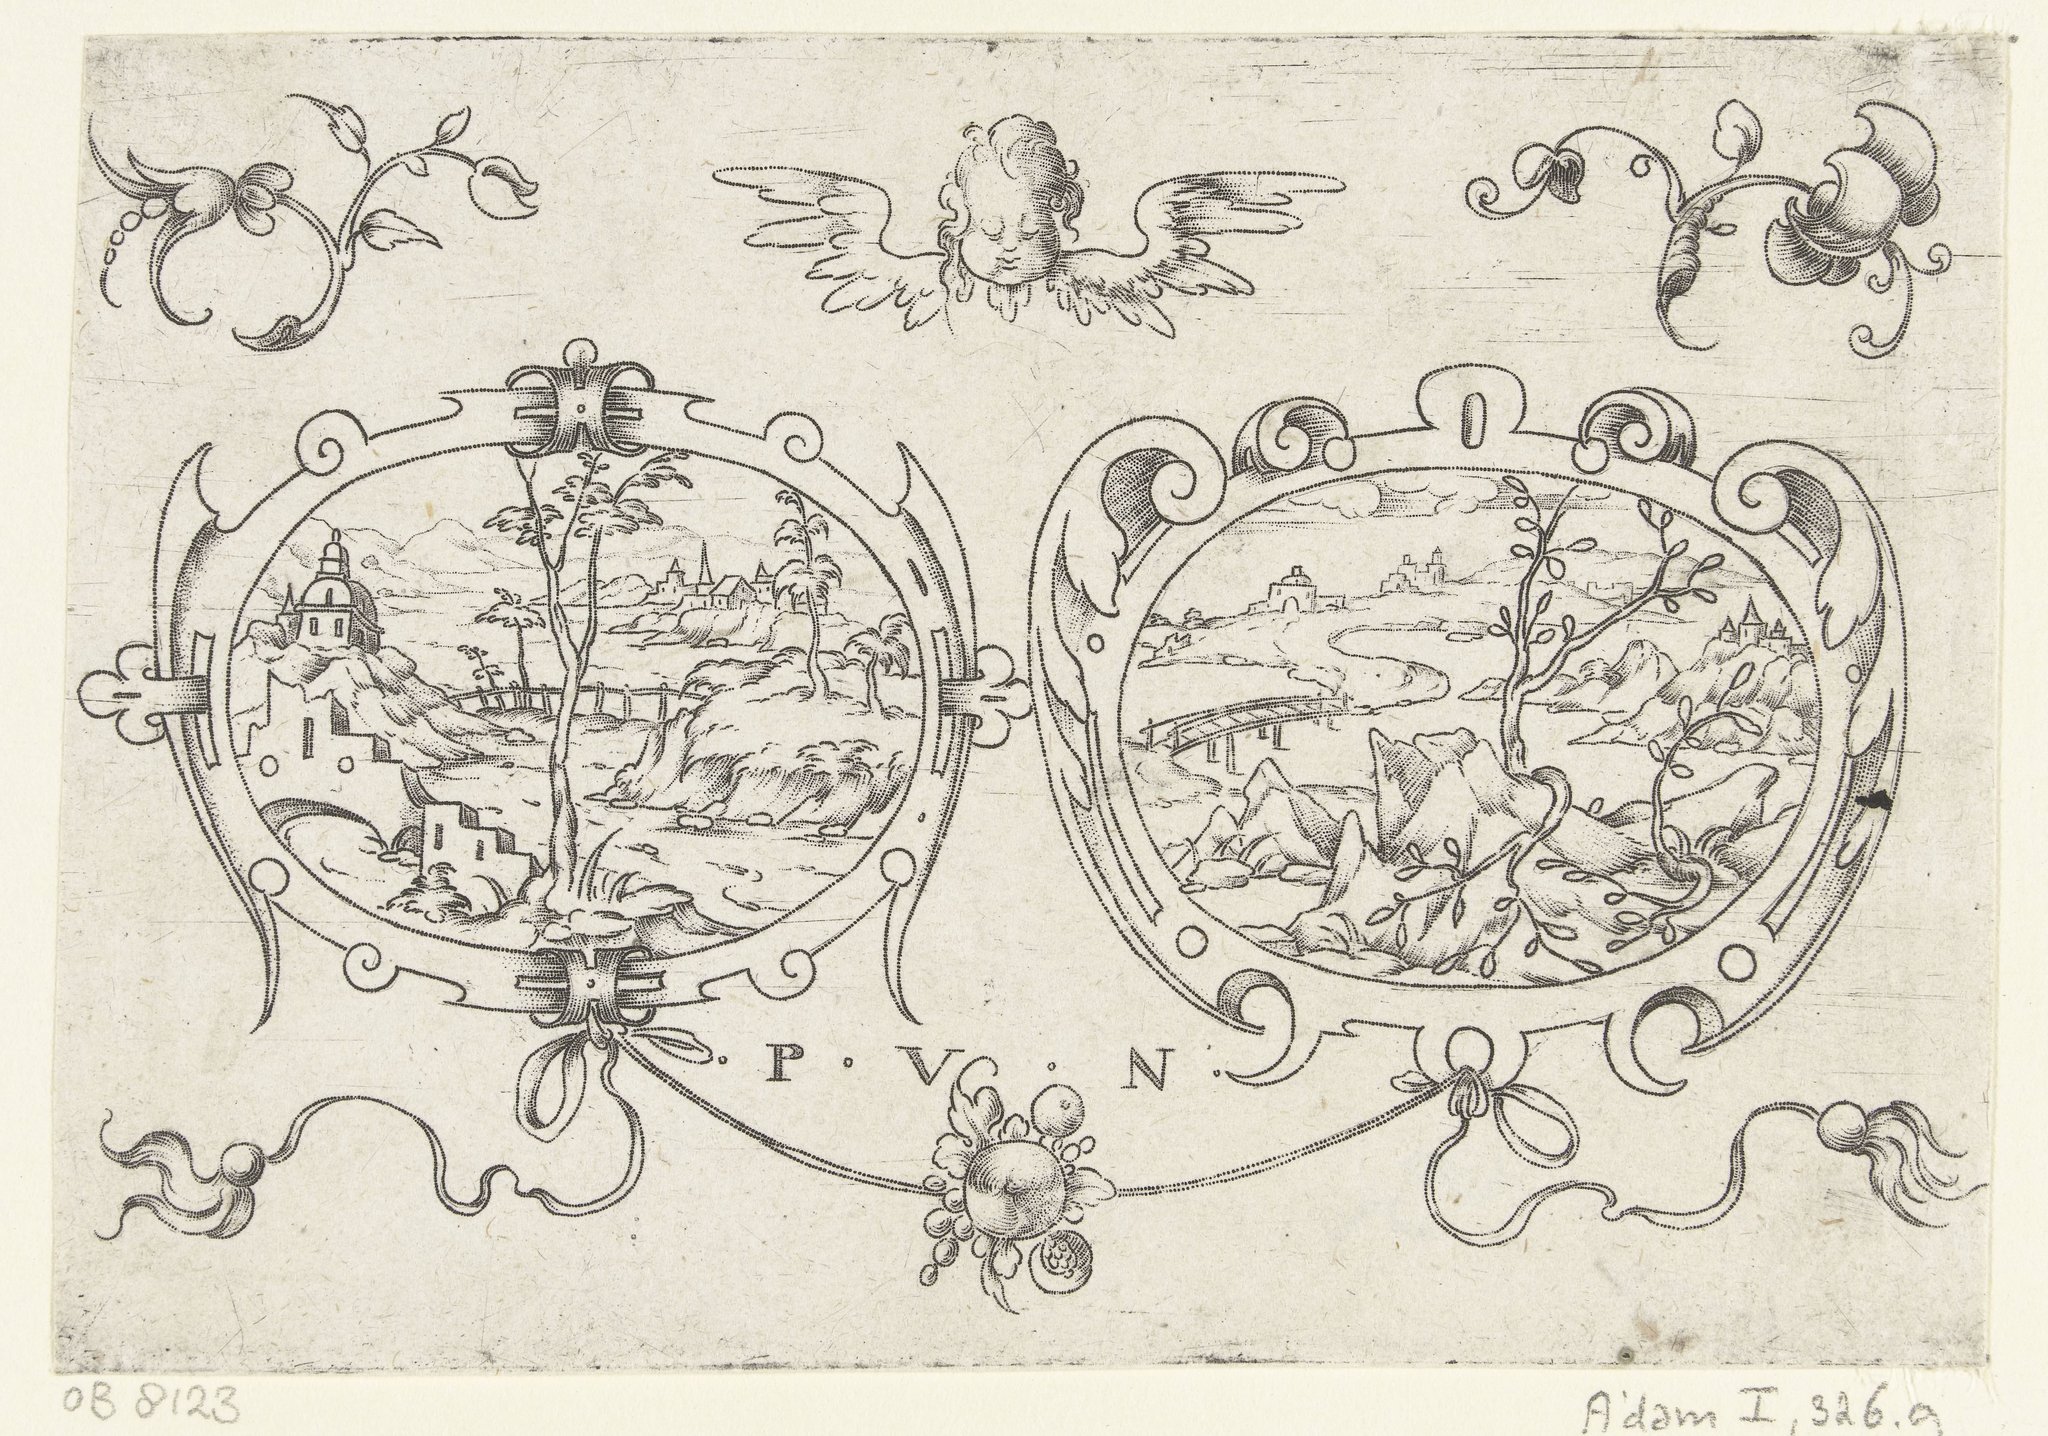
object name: ornament print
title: Ovale cartouches in een omlijsting van krulwerk met dieren in landschappen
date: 1600-1699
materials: paper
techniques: engraving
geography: germany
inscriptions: collector's mark: Lugt 240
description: Boven de ovalen bevindt zich een cherubijntje tussen twee bloemen, aan de ovalen hangt een guirlande. Uit serie van 12 bladen.